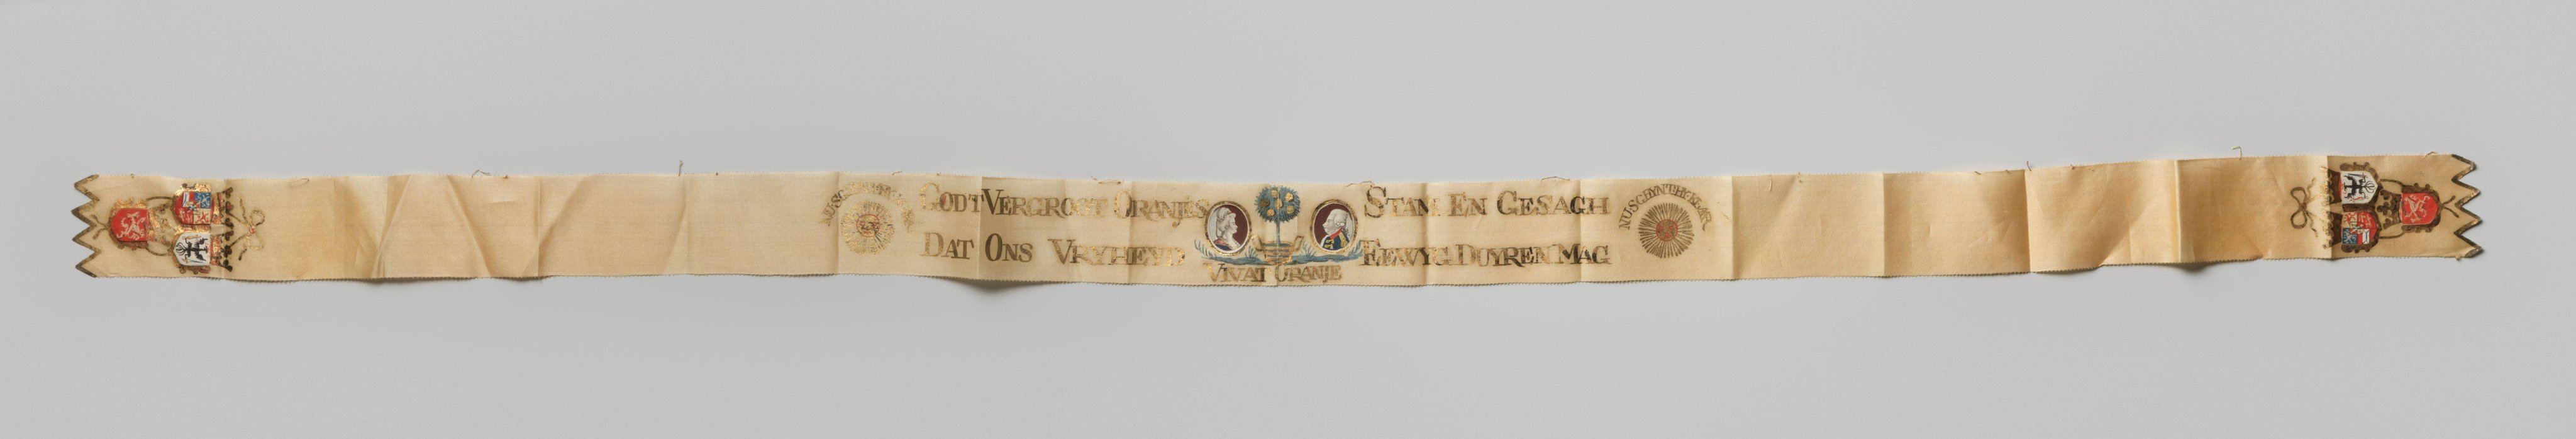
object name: ribbon material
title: Oranjelint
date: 1725-1750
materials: paper, silk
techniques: printing, weave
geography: netherlands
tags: the hague, william v (prince of orange), berlin, painter, draughtsman, wilhelmina of prussia (princess of orange)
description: Lint met gekartelde uiteinden en centraal twee medaillons met portretten van Wilhelmina (links) en Willem V. Tussen hen in een oranjeboom in een ronde bak. Links en rechts iseen oranjezon weergegeven. Aan de uiteinden van het lint een drietal gekroonde wapenschildjes (Oranje-Nassau, Pruisische adelaar, Nederlandse leeuw), door een lint met strik aan elkaar verbonden. Opschrift: Nu. Sgijnt. Hy. Klaar. GODT VERGROOT ORANJES STAM EN GESACH DAT ONS VREYHEYD EEWYG DUYREN MAG VIVAT ORANJE. Nu. Sgijnt. Hy. Klaar.